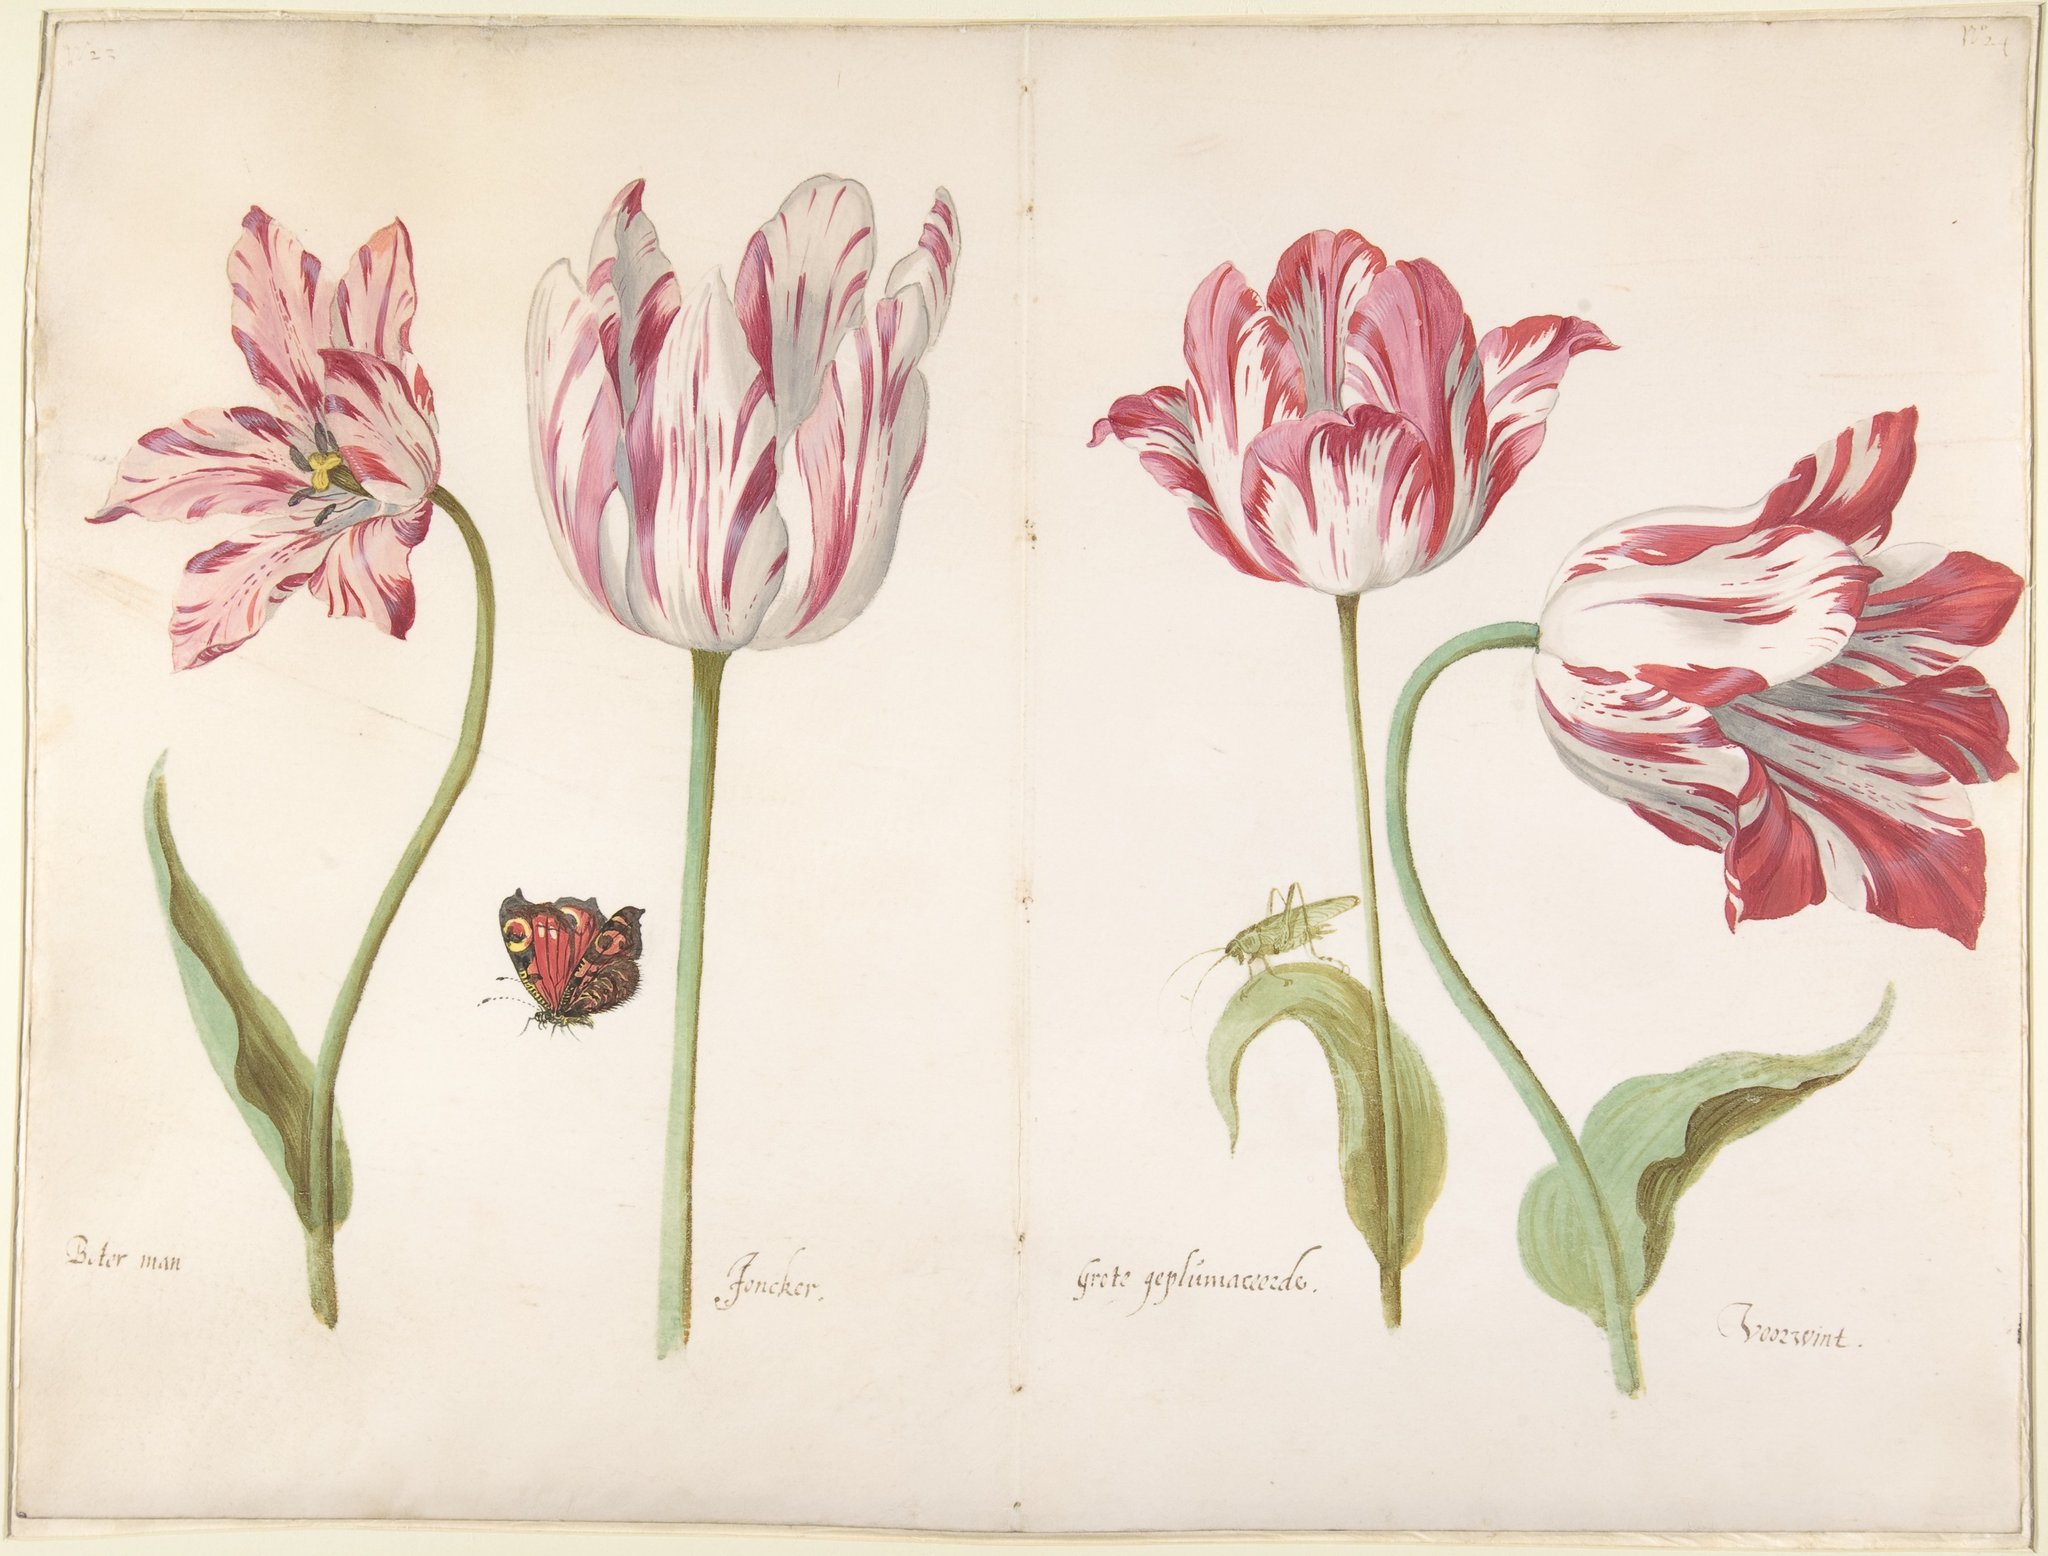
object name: drawing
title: Four Tulips: Boter man (Butter Man), Joncker (Nobleman), Grote geplumaceerde (The Great Plumed One), and Voorwint (With the Wind)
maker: jacob marrel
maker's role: draughtsman, painter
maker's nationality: german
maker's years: 1614-1681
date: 1635-1645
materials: parchment, watercolor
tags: insects,butterflies,tulips